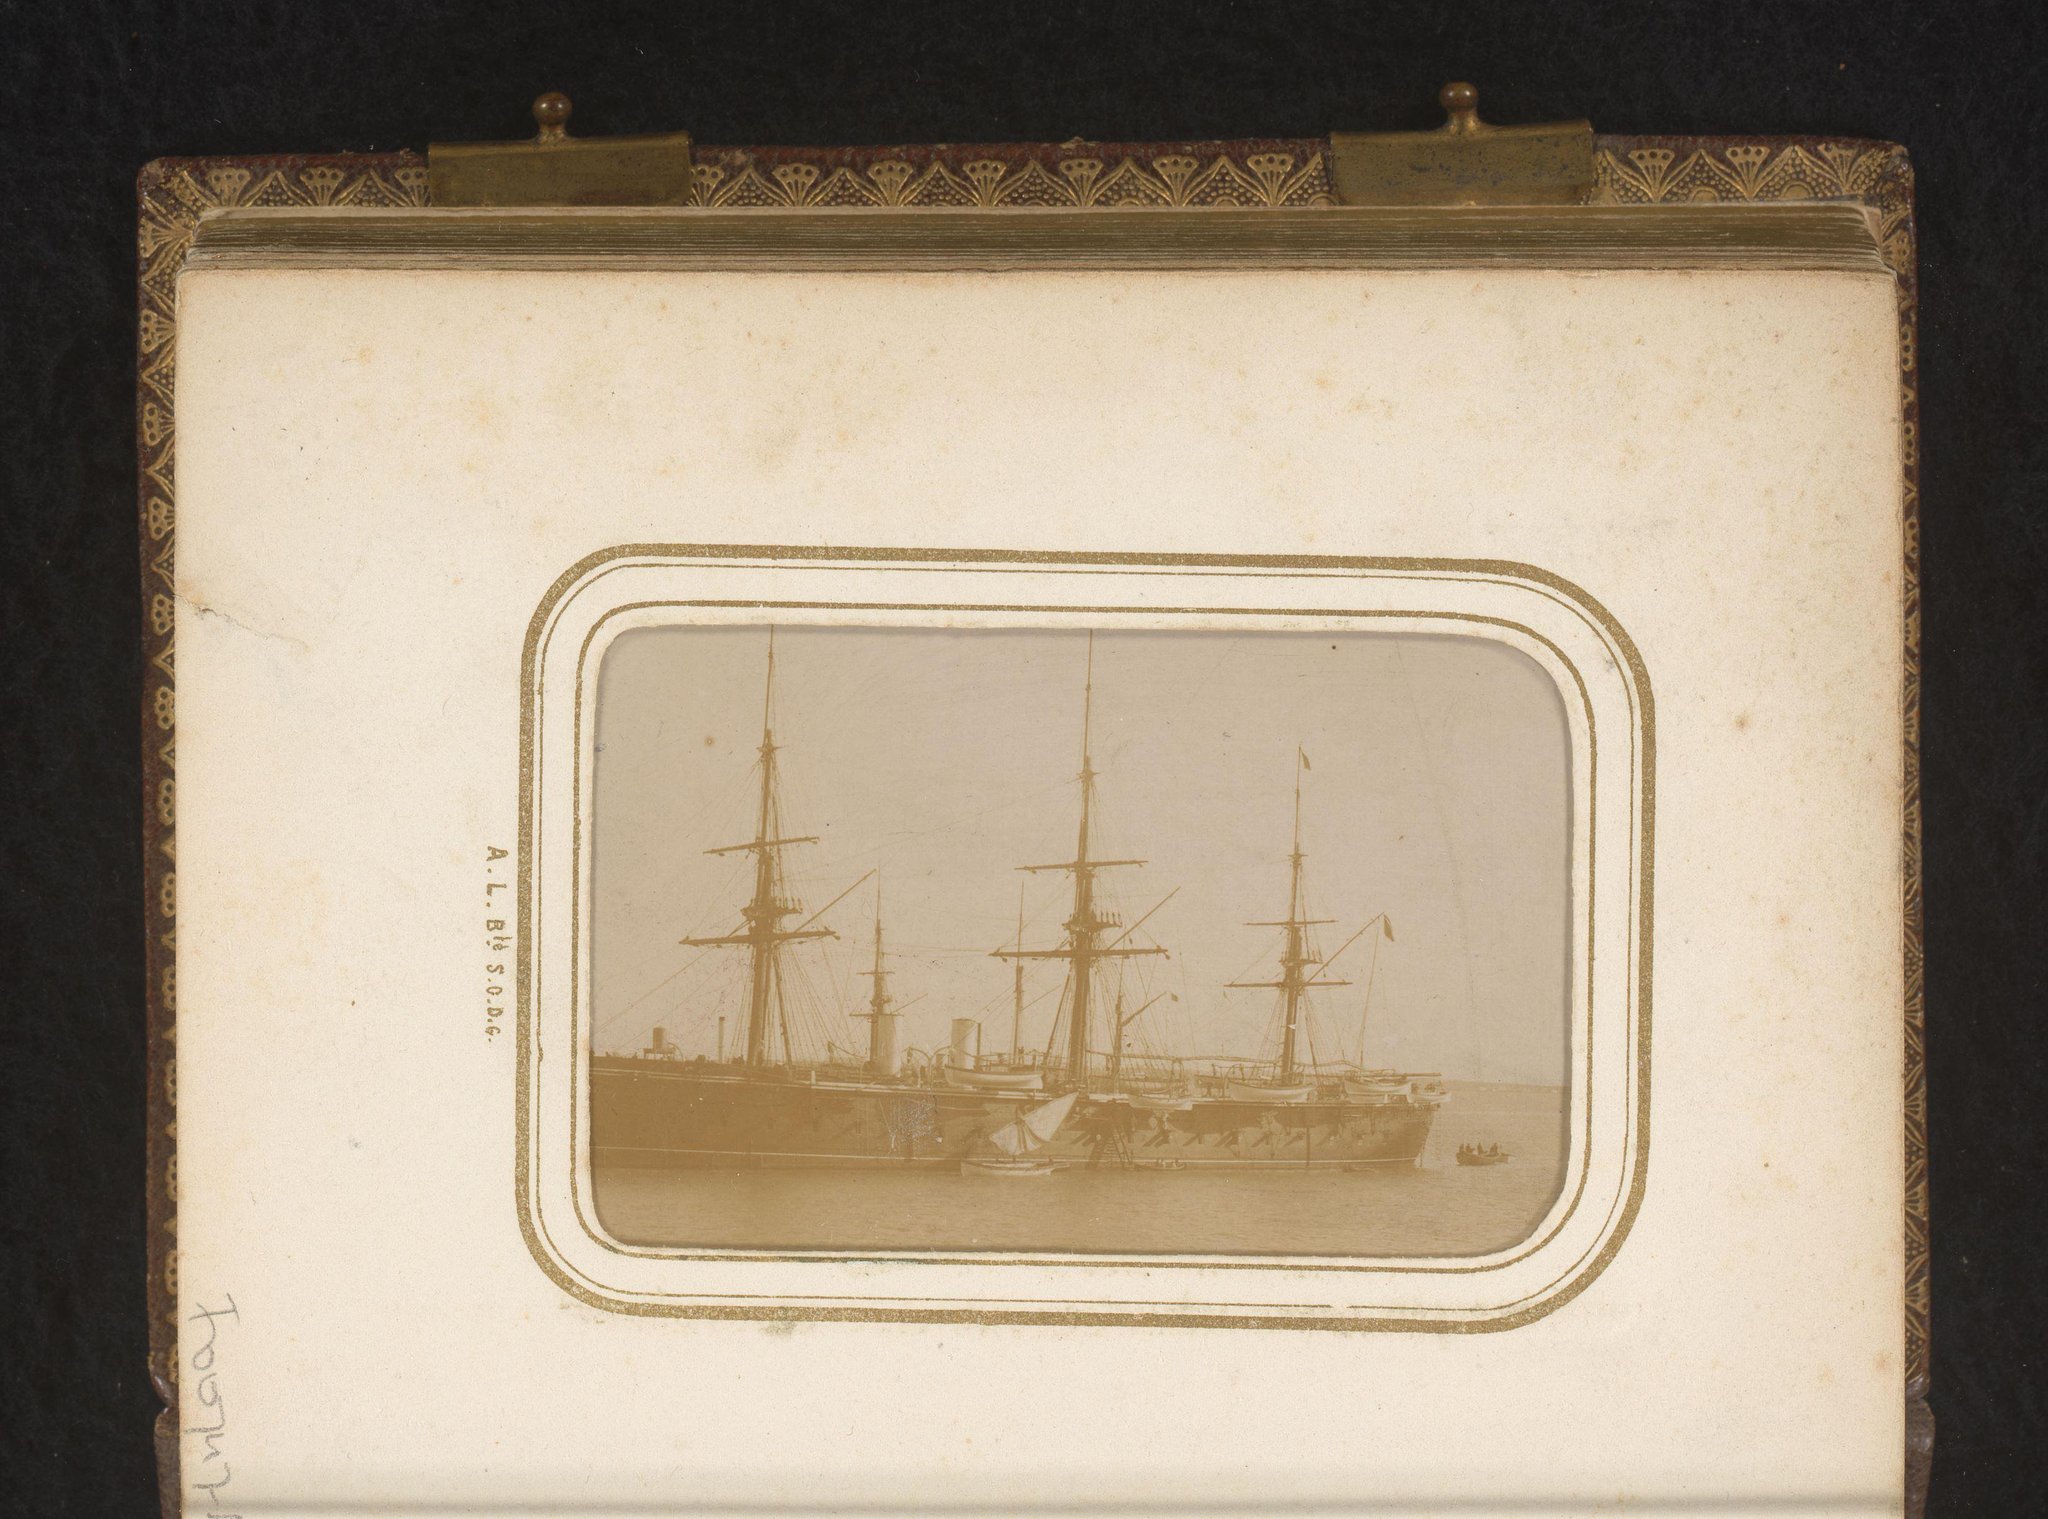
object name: album leaf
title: Schip te water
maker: Anonymous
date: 1860-1890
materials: cardboard, photographic support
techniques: collodion silver print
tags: landscapes with waters, waterscapes, seascapes (in the temperate zone), ships (in general)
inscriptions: inscription: ‘A.L. B.te S.C.D.G.’